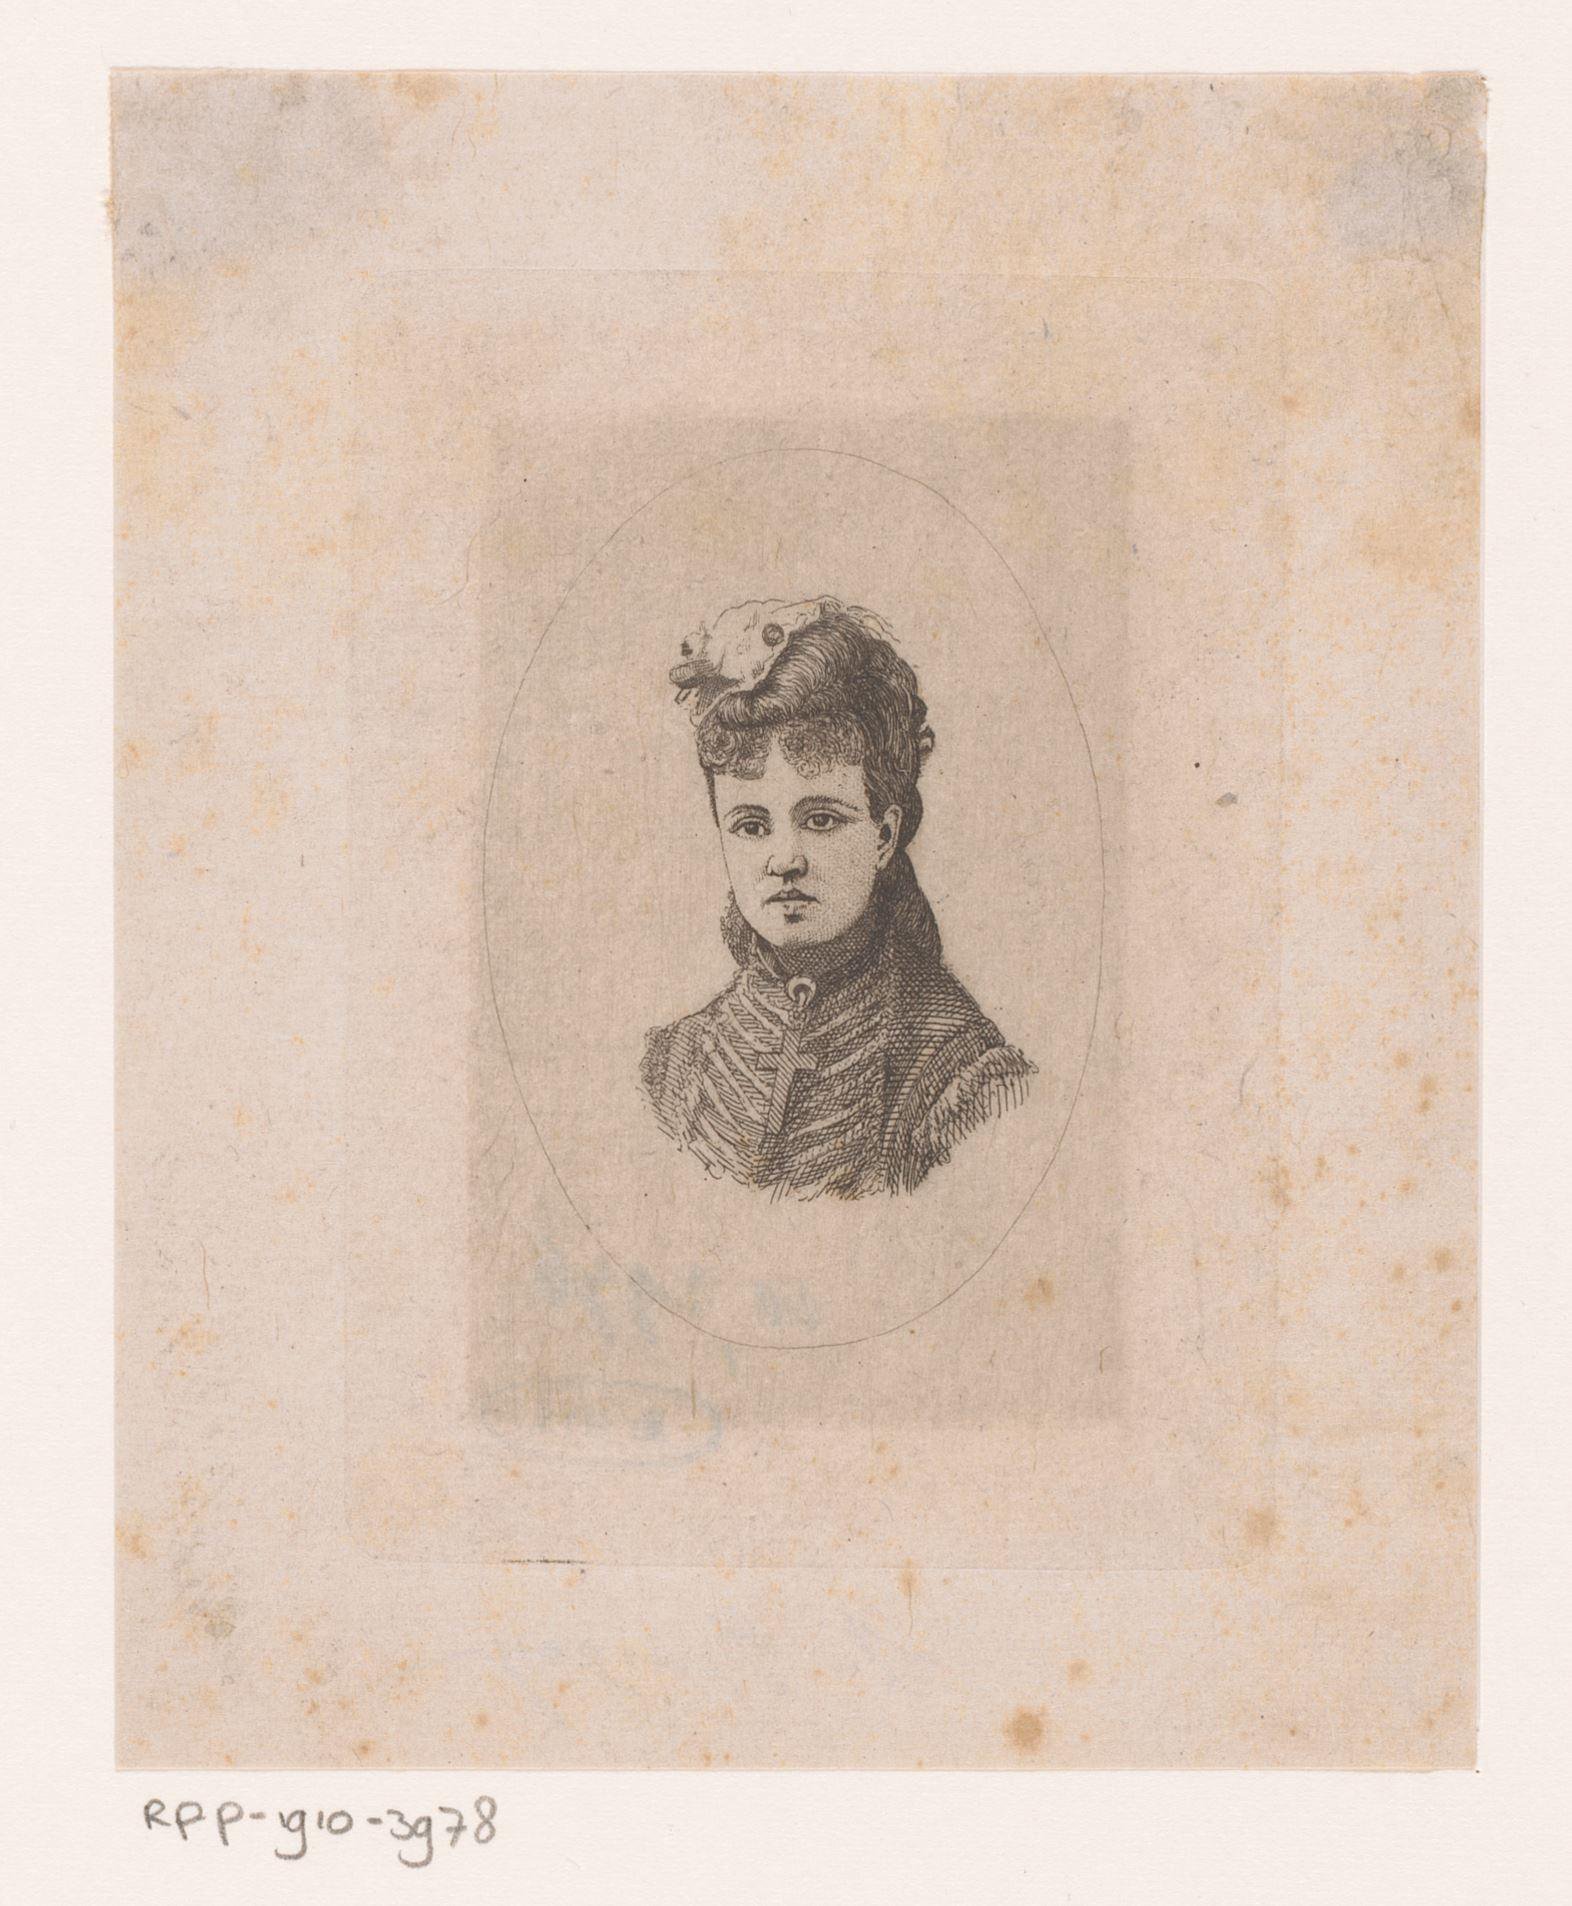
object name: print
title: Portret van een onbekende vrouw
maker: louis jaugey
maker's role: print maker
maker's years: 1837-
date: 1850-1899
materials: paper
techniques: etching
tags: adult woman, head-gear, historical persons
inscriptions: collector's mark: Lugt 2228